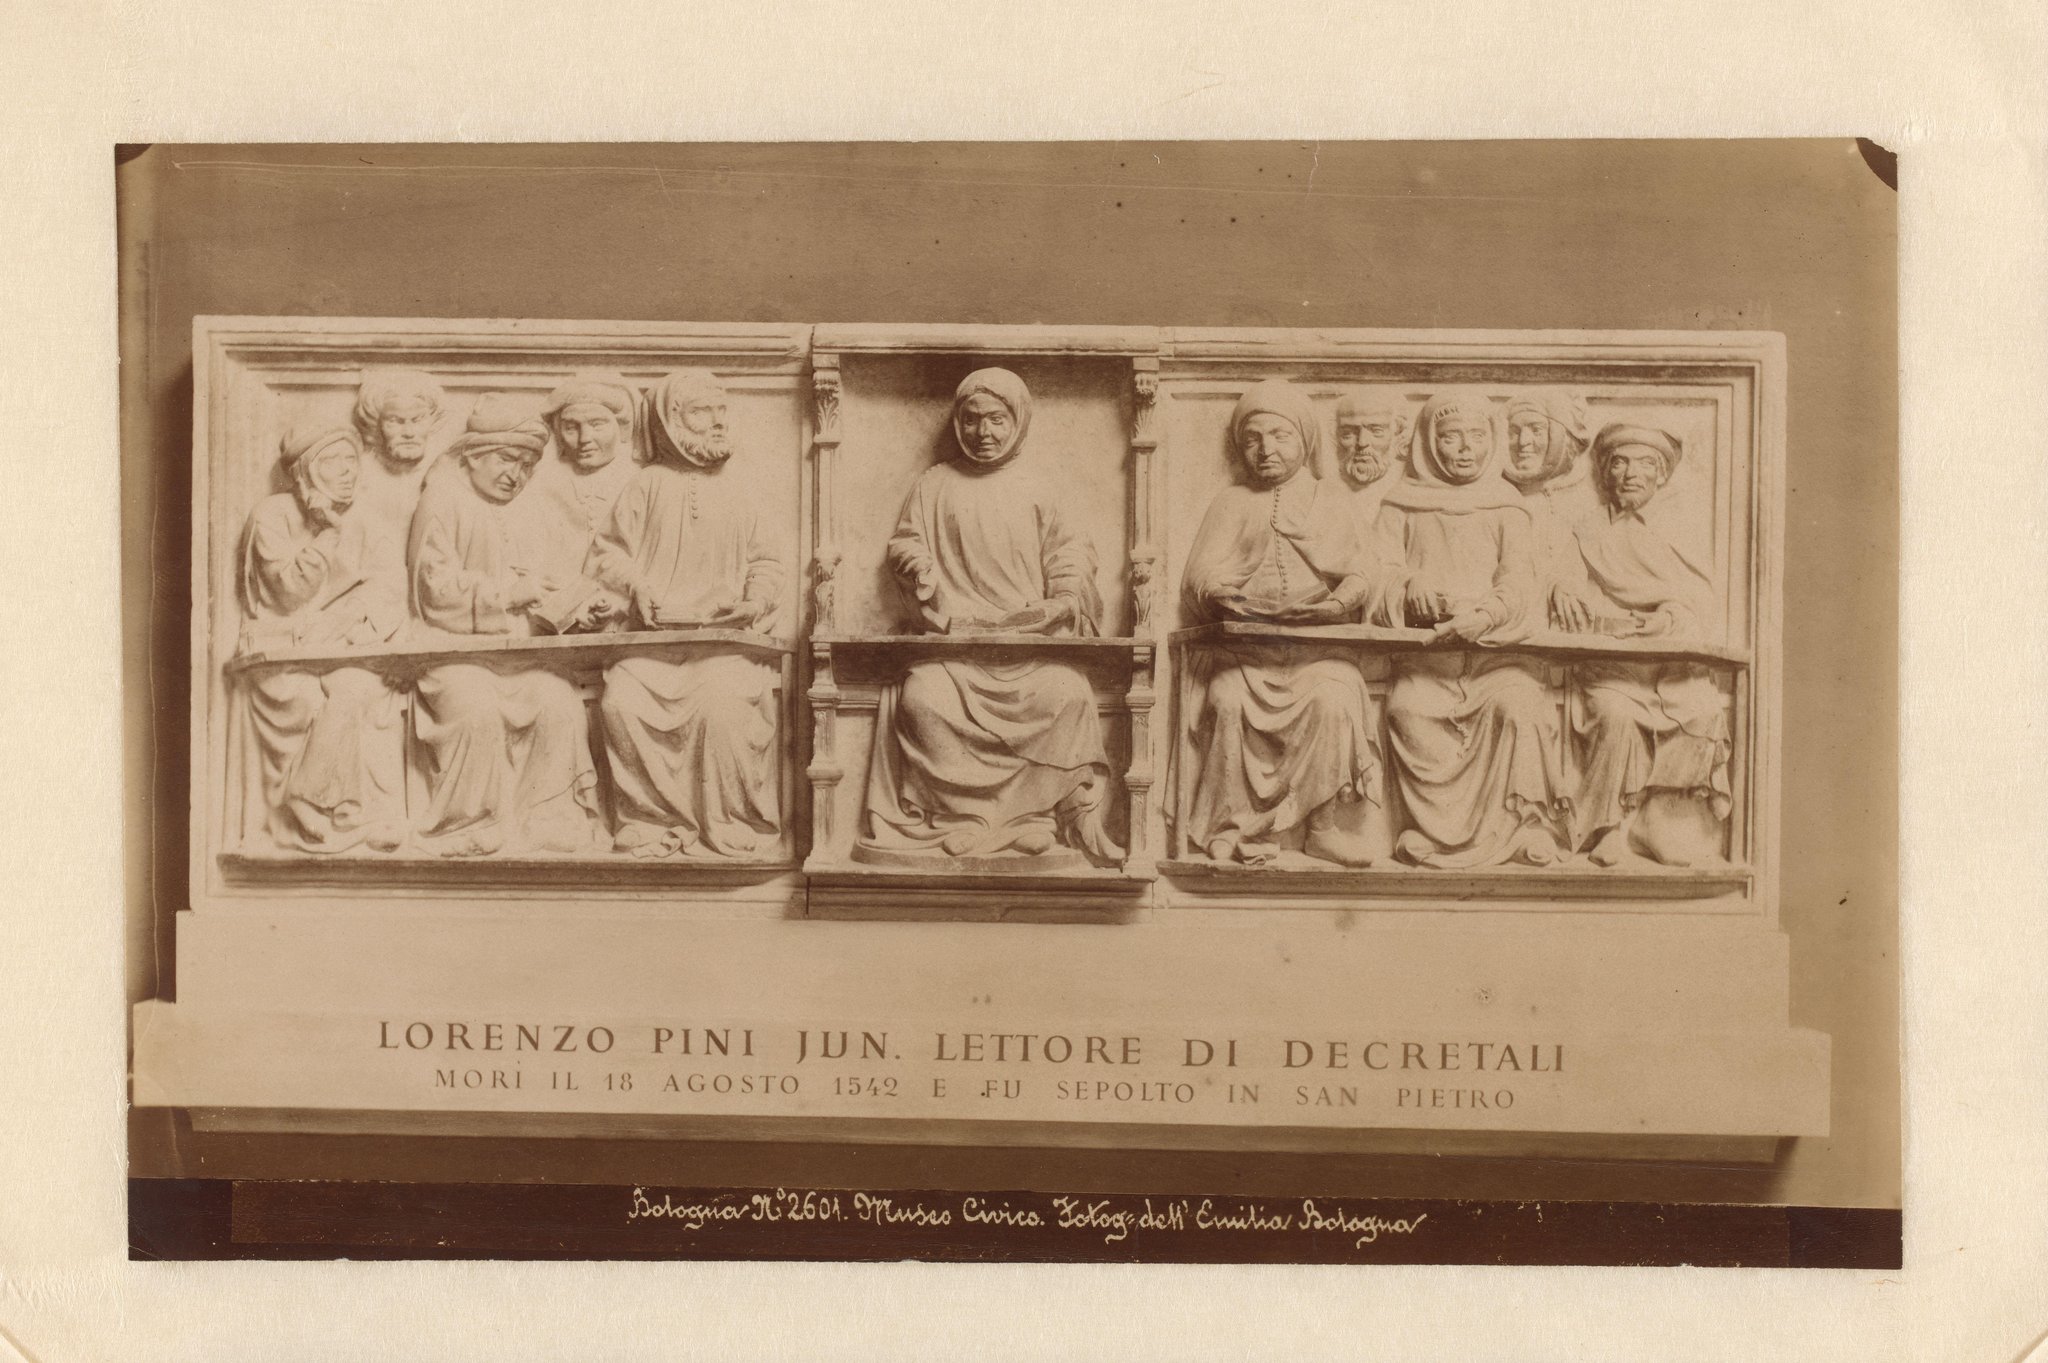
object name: photograph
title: Bologna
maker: pietro poppi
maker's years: 1833-1914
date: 1850-1900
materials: photographic support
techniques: albumen print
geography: bologna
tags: sculpture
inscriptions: inscription: ‘Fotogr. dell'Emilia Bologna’, number: ‘No. 2601.’